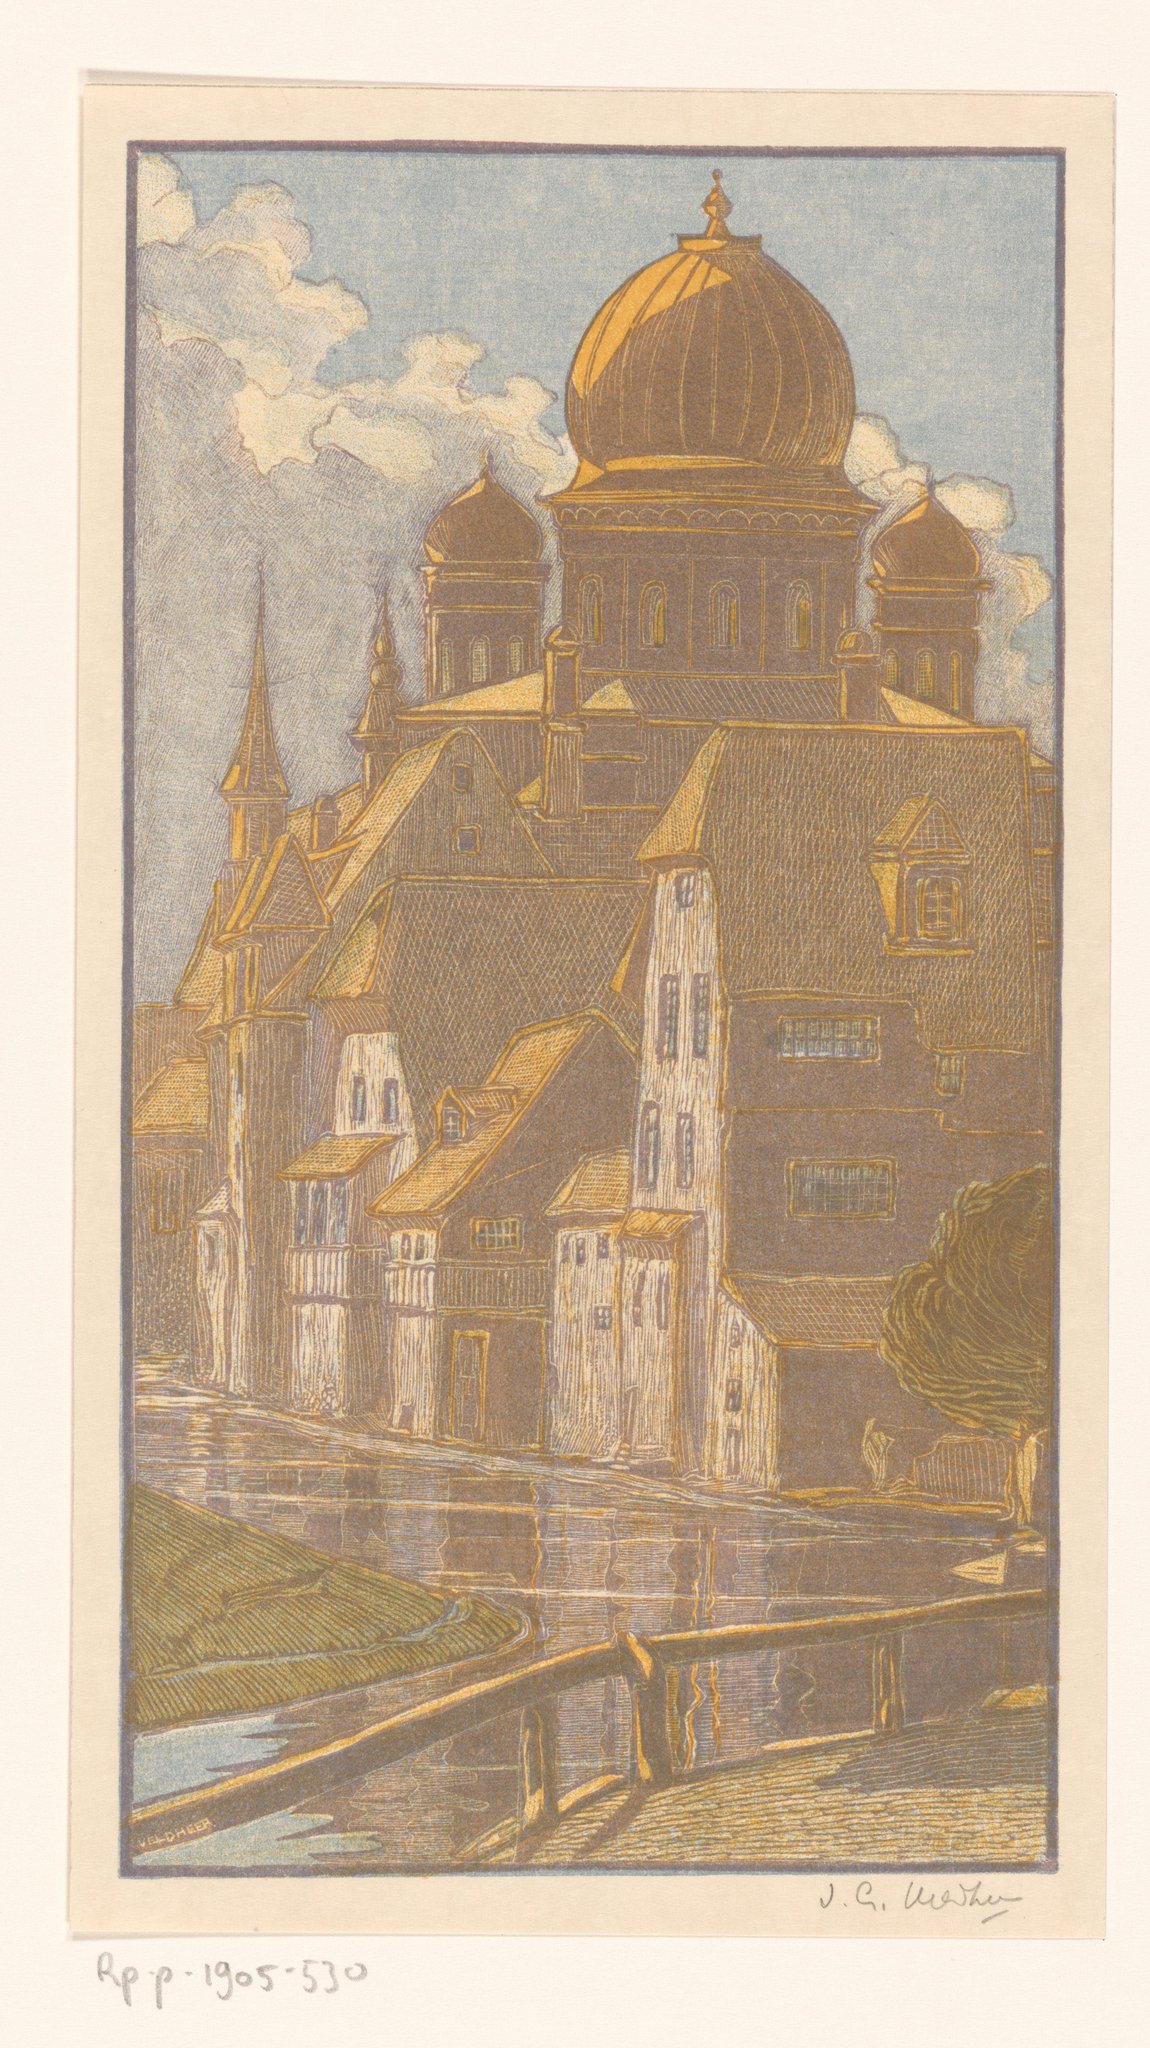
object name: print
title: Gezicht op de synagoge van Neurenberg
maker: jacobus gerardus veldheer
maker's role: draughtsman, print maker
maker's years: 1866-1954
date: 1876-1905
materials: paper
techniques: woodcut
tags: the synagogue (as building and place of worship ~ jewish religion)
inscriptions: collector's mark: Lugt 2228